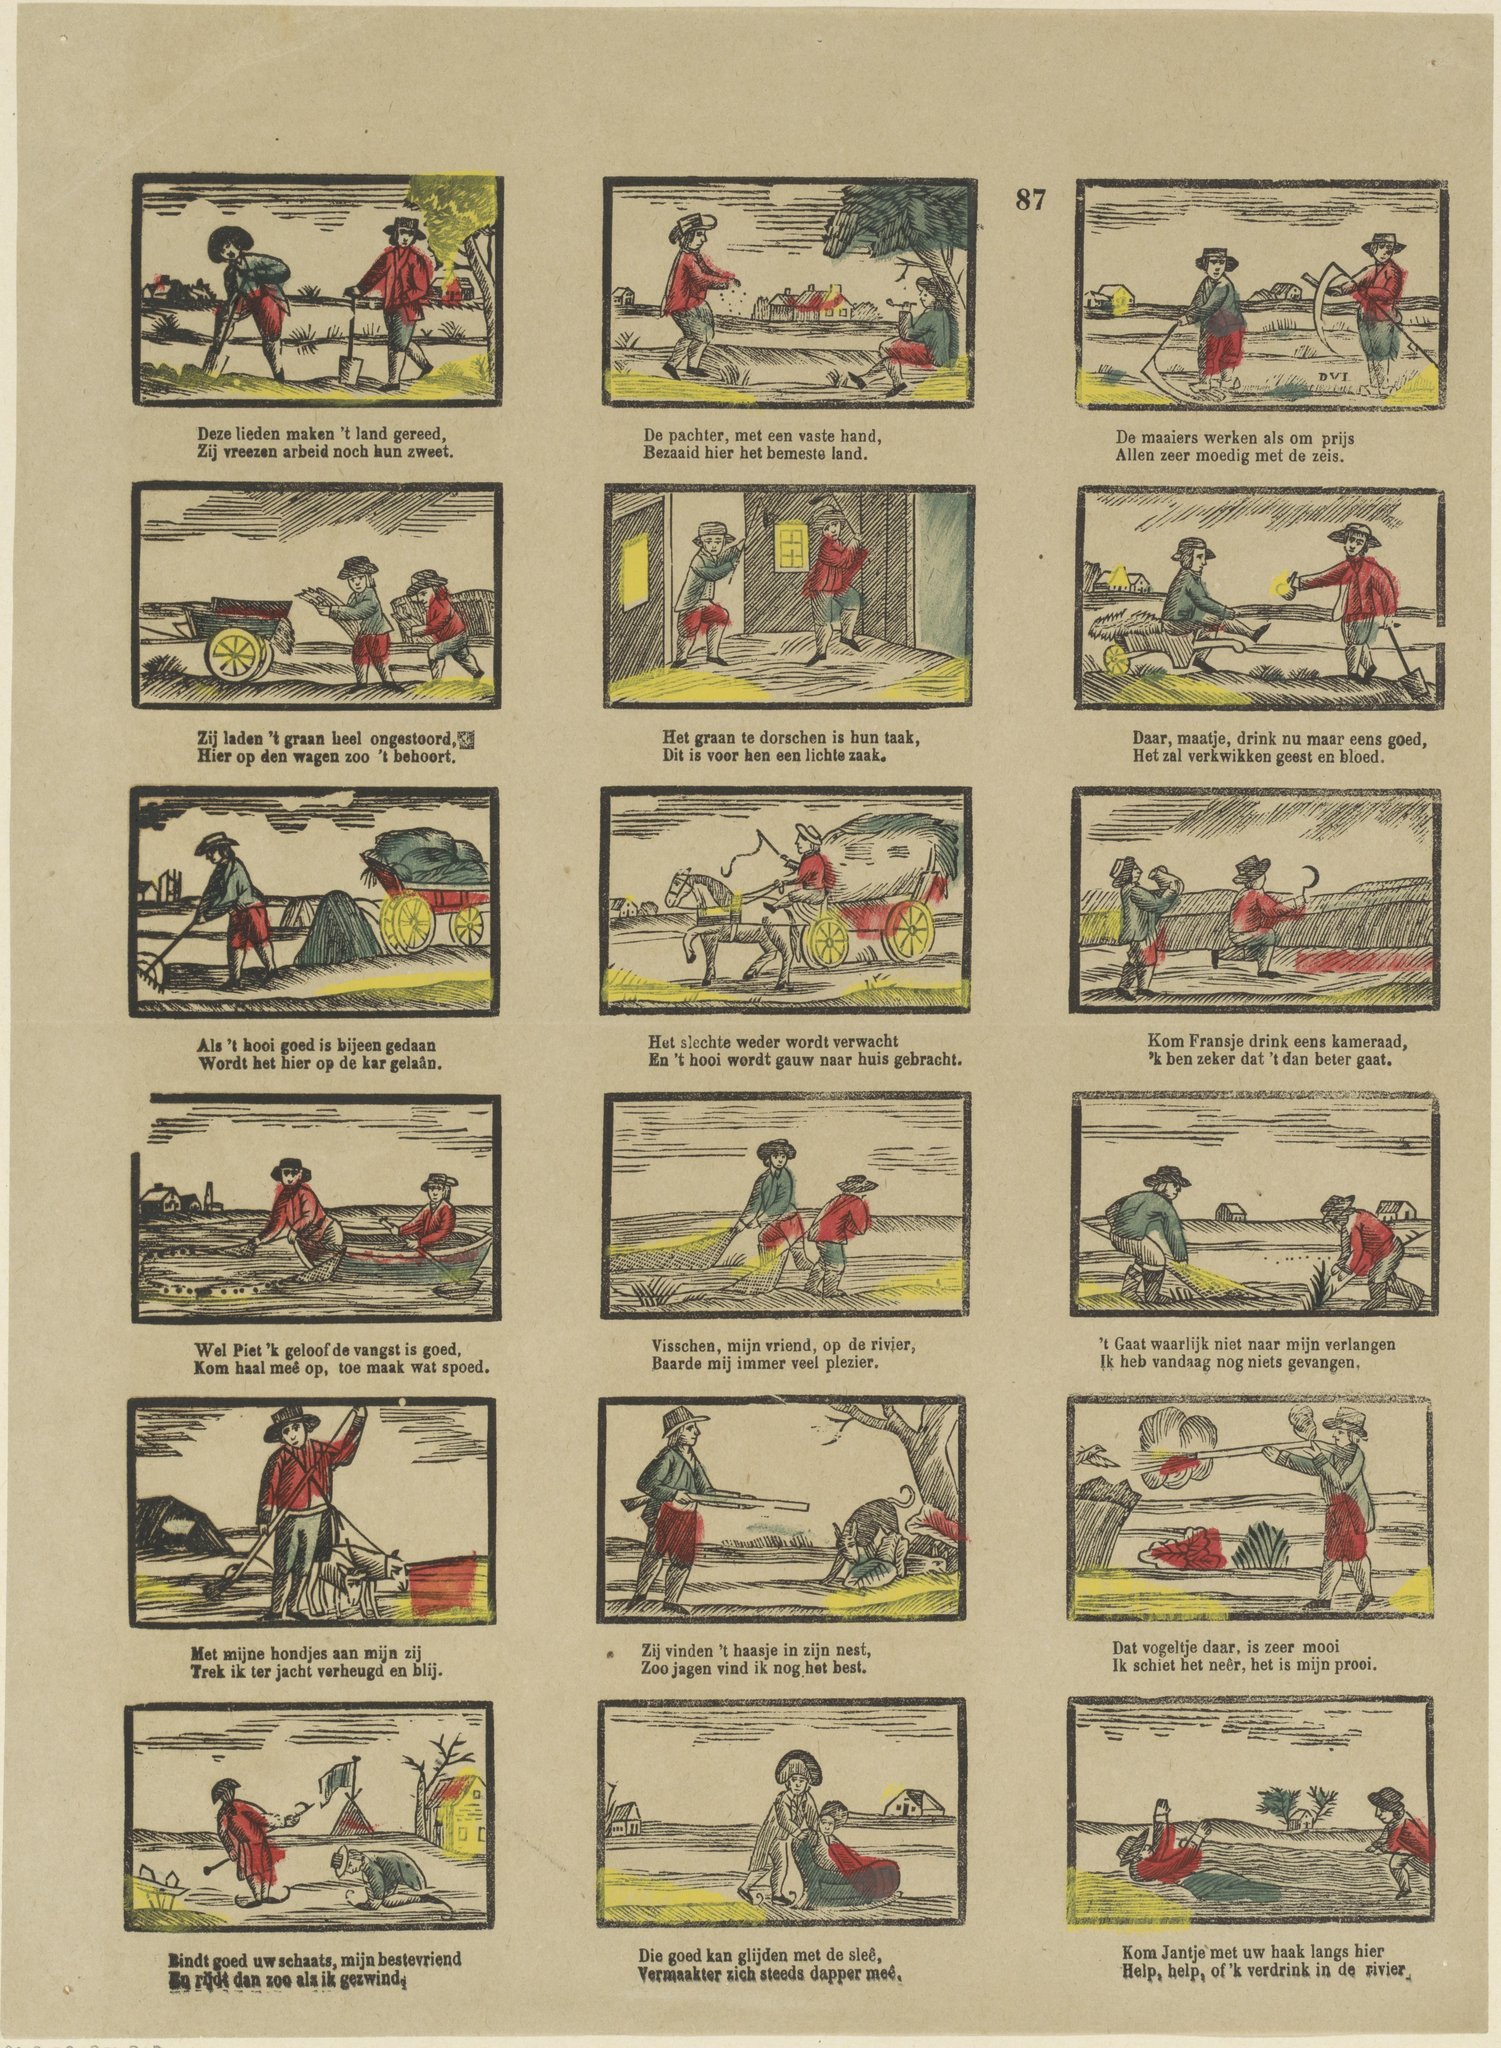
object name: popular print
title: Landbouw, visvangst, jacht en wintervermaak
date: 1866-1902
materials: paper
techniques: colour, letterpress printing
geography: turnhout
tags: fresh-water fishery, bird hunting, skates (winter sports), agriculture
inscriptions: collector's mark: Lugt 2760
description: Blad met 18 voorstellingen van landbouw, visvangst, jacht en winterse activiteiten. Onder elke voorstelling een tweeregelig vers. Genummerd midden boven: 87.